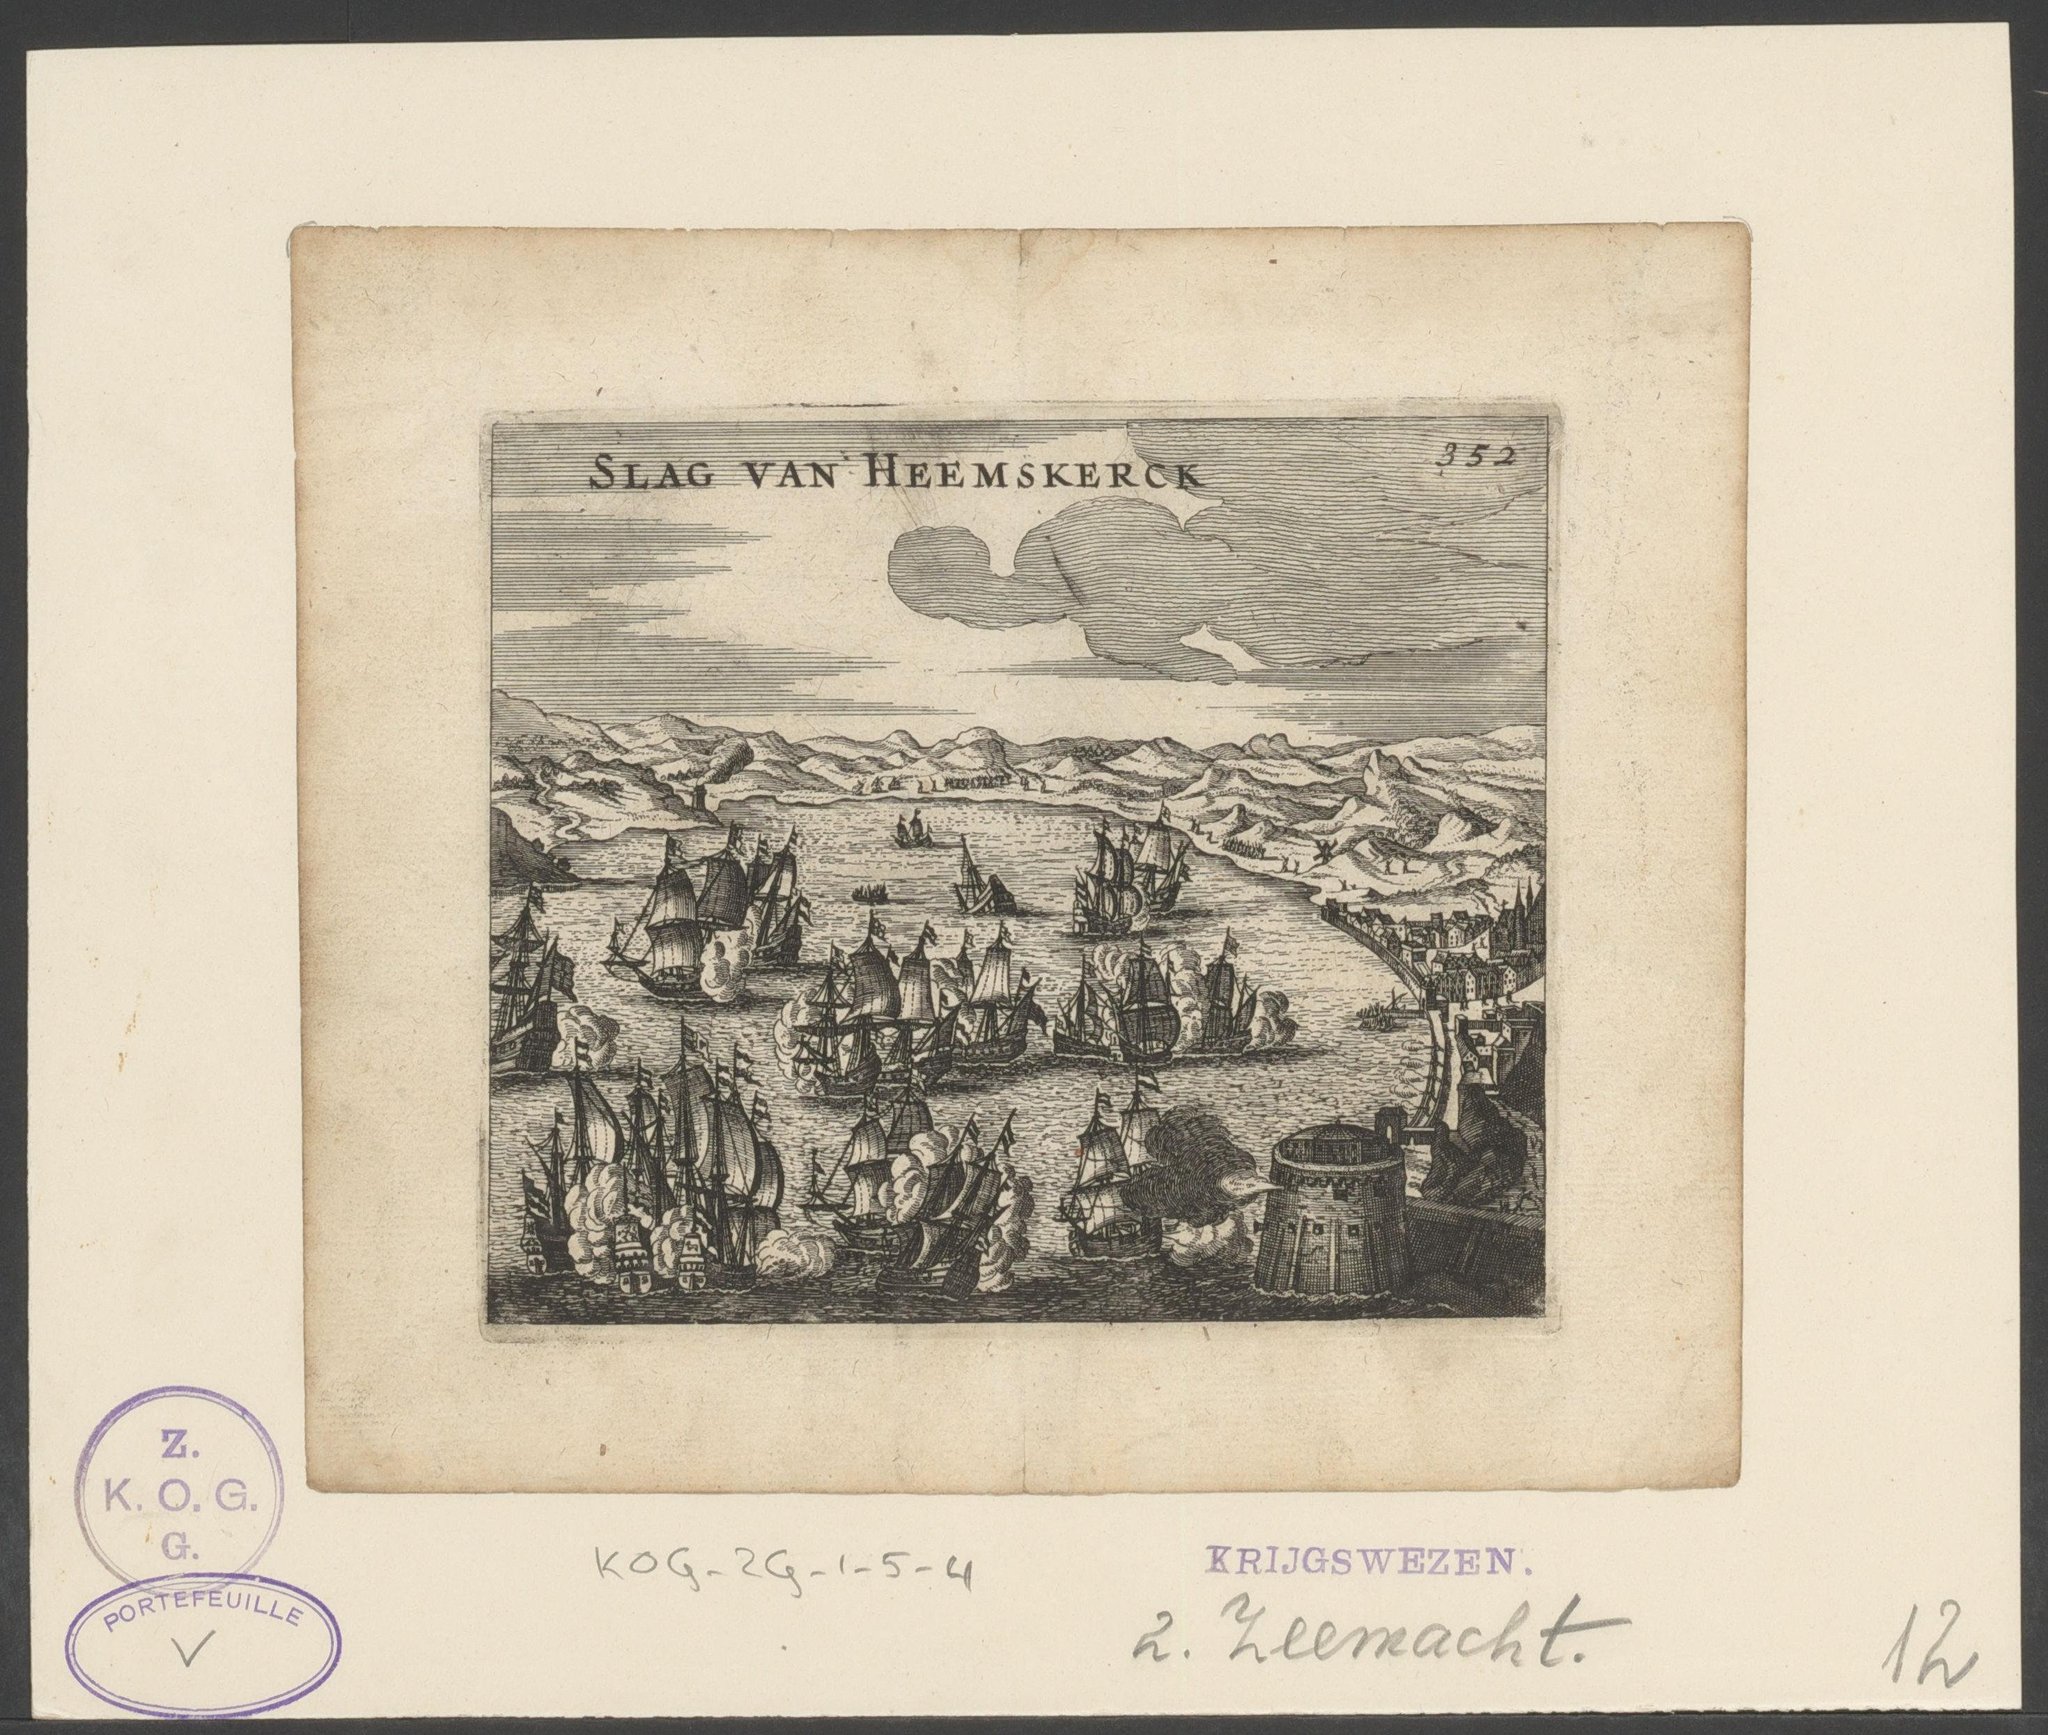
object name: print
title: Zeeslag bij Gibraltar, 1607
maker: Anonymous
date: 1664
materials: paper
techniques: etching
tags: (military) attack (+ naval force), enemy ~war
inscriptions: stamp, collector's mark: Lugt 1641, stamp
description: Prent waarschijnlijk uit: Montanus, Arnoldus. 'T leven en bedryf der prinsen van Oranje, Wilhelm de eerste, Maurits, Frederik Henrik, Wilhem de tweede, Wilhem de derde : aengehecht met de daden der Nassouwsche stam, van het jaar 682 tot dese tijd. 5 dln. Amsterdam: Arent van den Heuvel en Samuel Imbrecht, 1664, Band I, dl. Maurits.